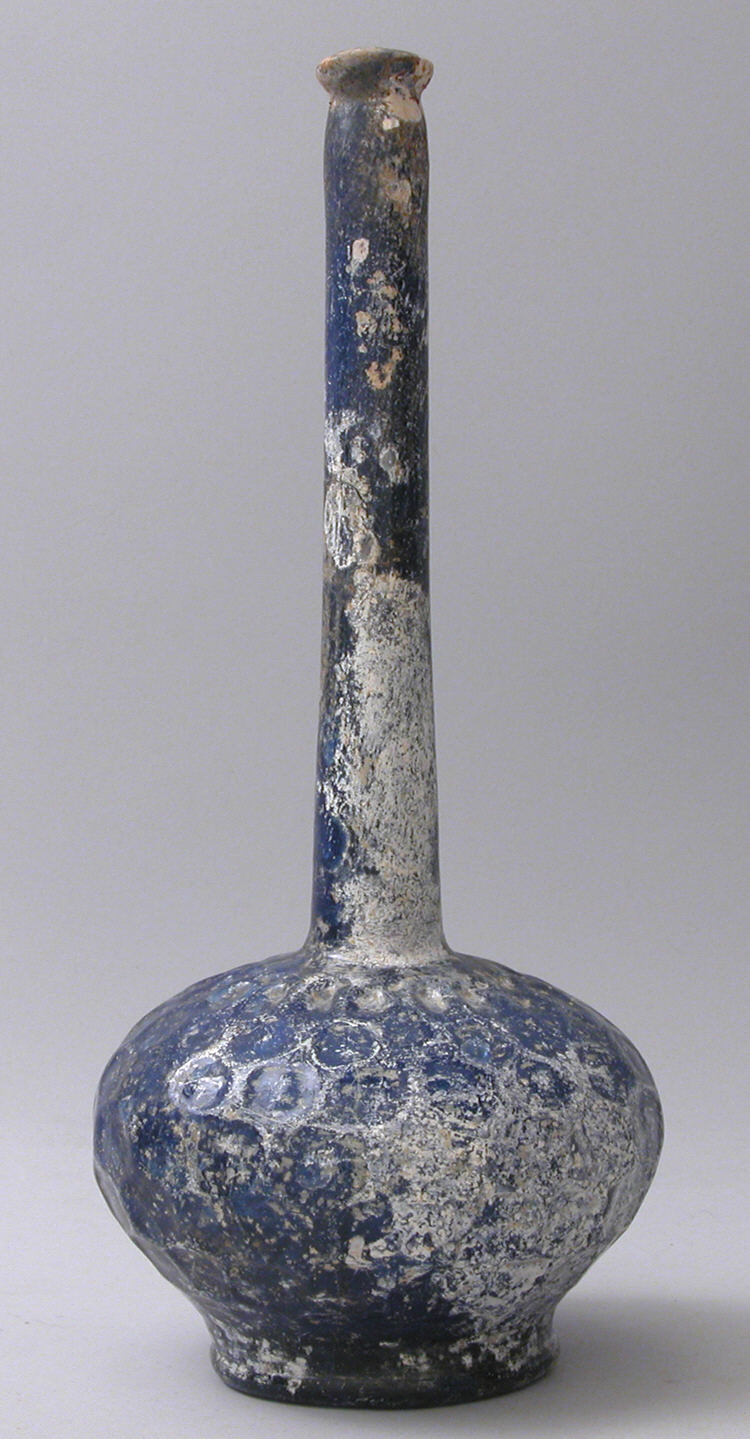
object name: bottle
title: Tall-Necked Bottle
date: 1101-1300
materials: glass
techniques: glassblowing, molding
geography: iran